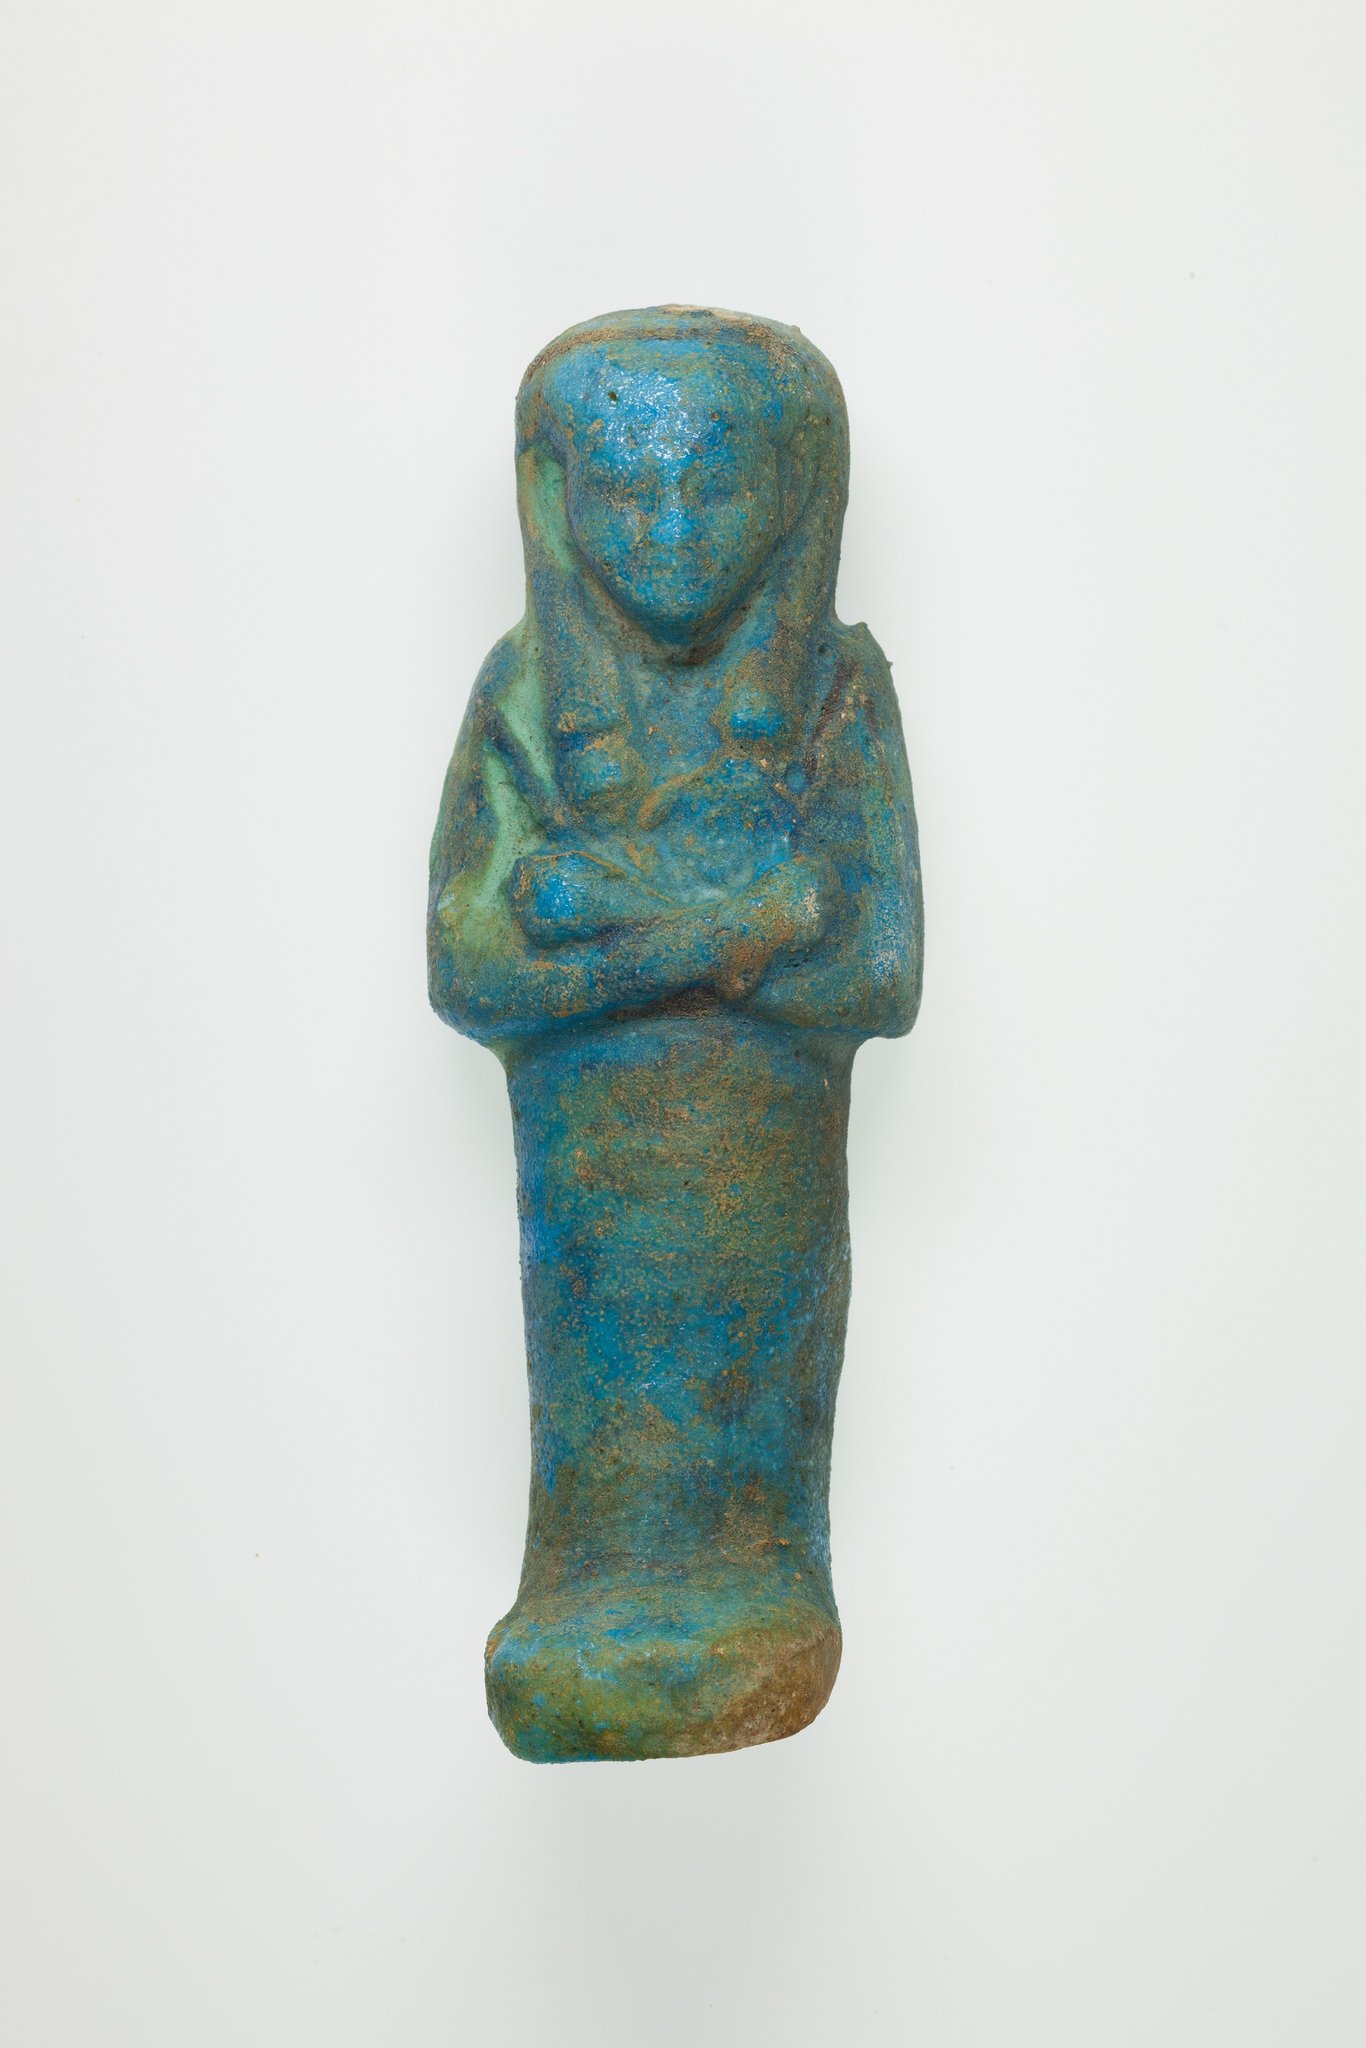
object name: shabti, henettawy c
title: Worker Shabti of Henettawy (C), Daughter of Isetemkheb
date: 990-970 BCE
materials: faience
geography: egypt